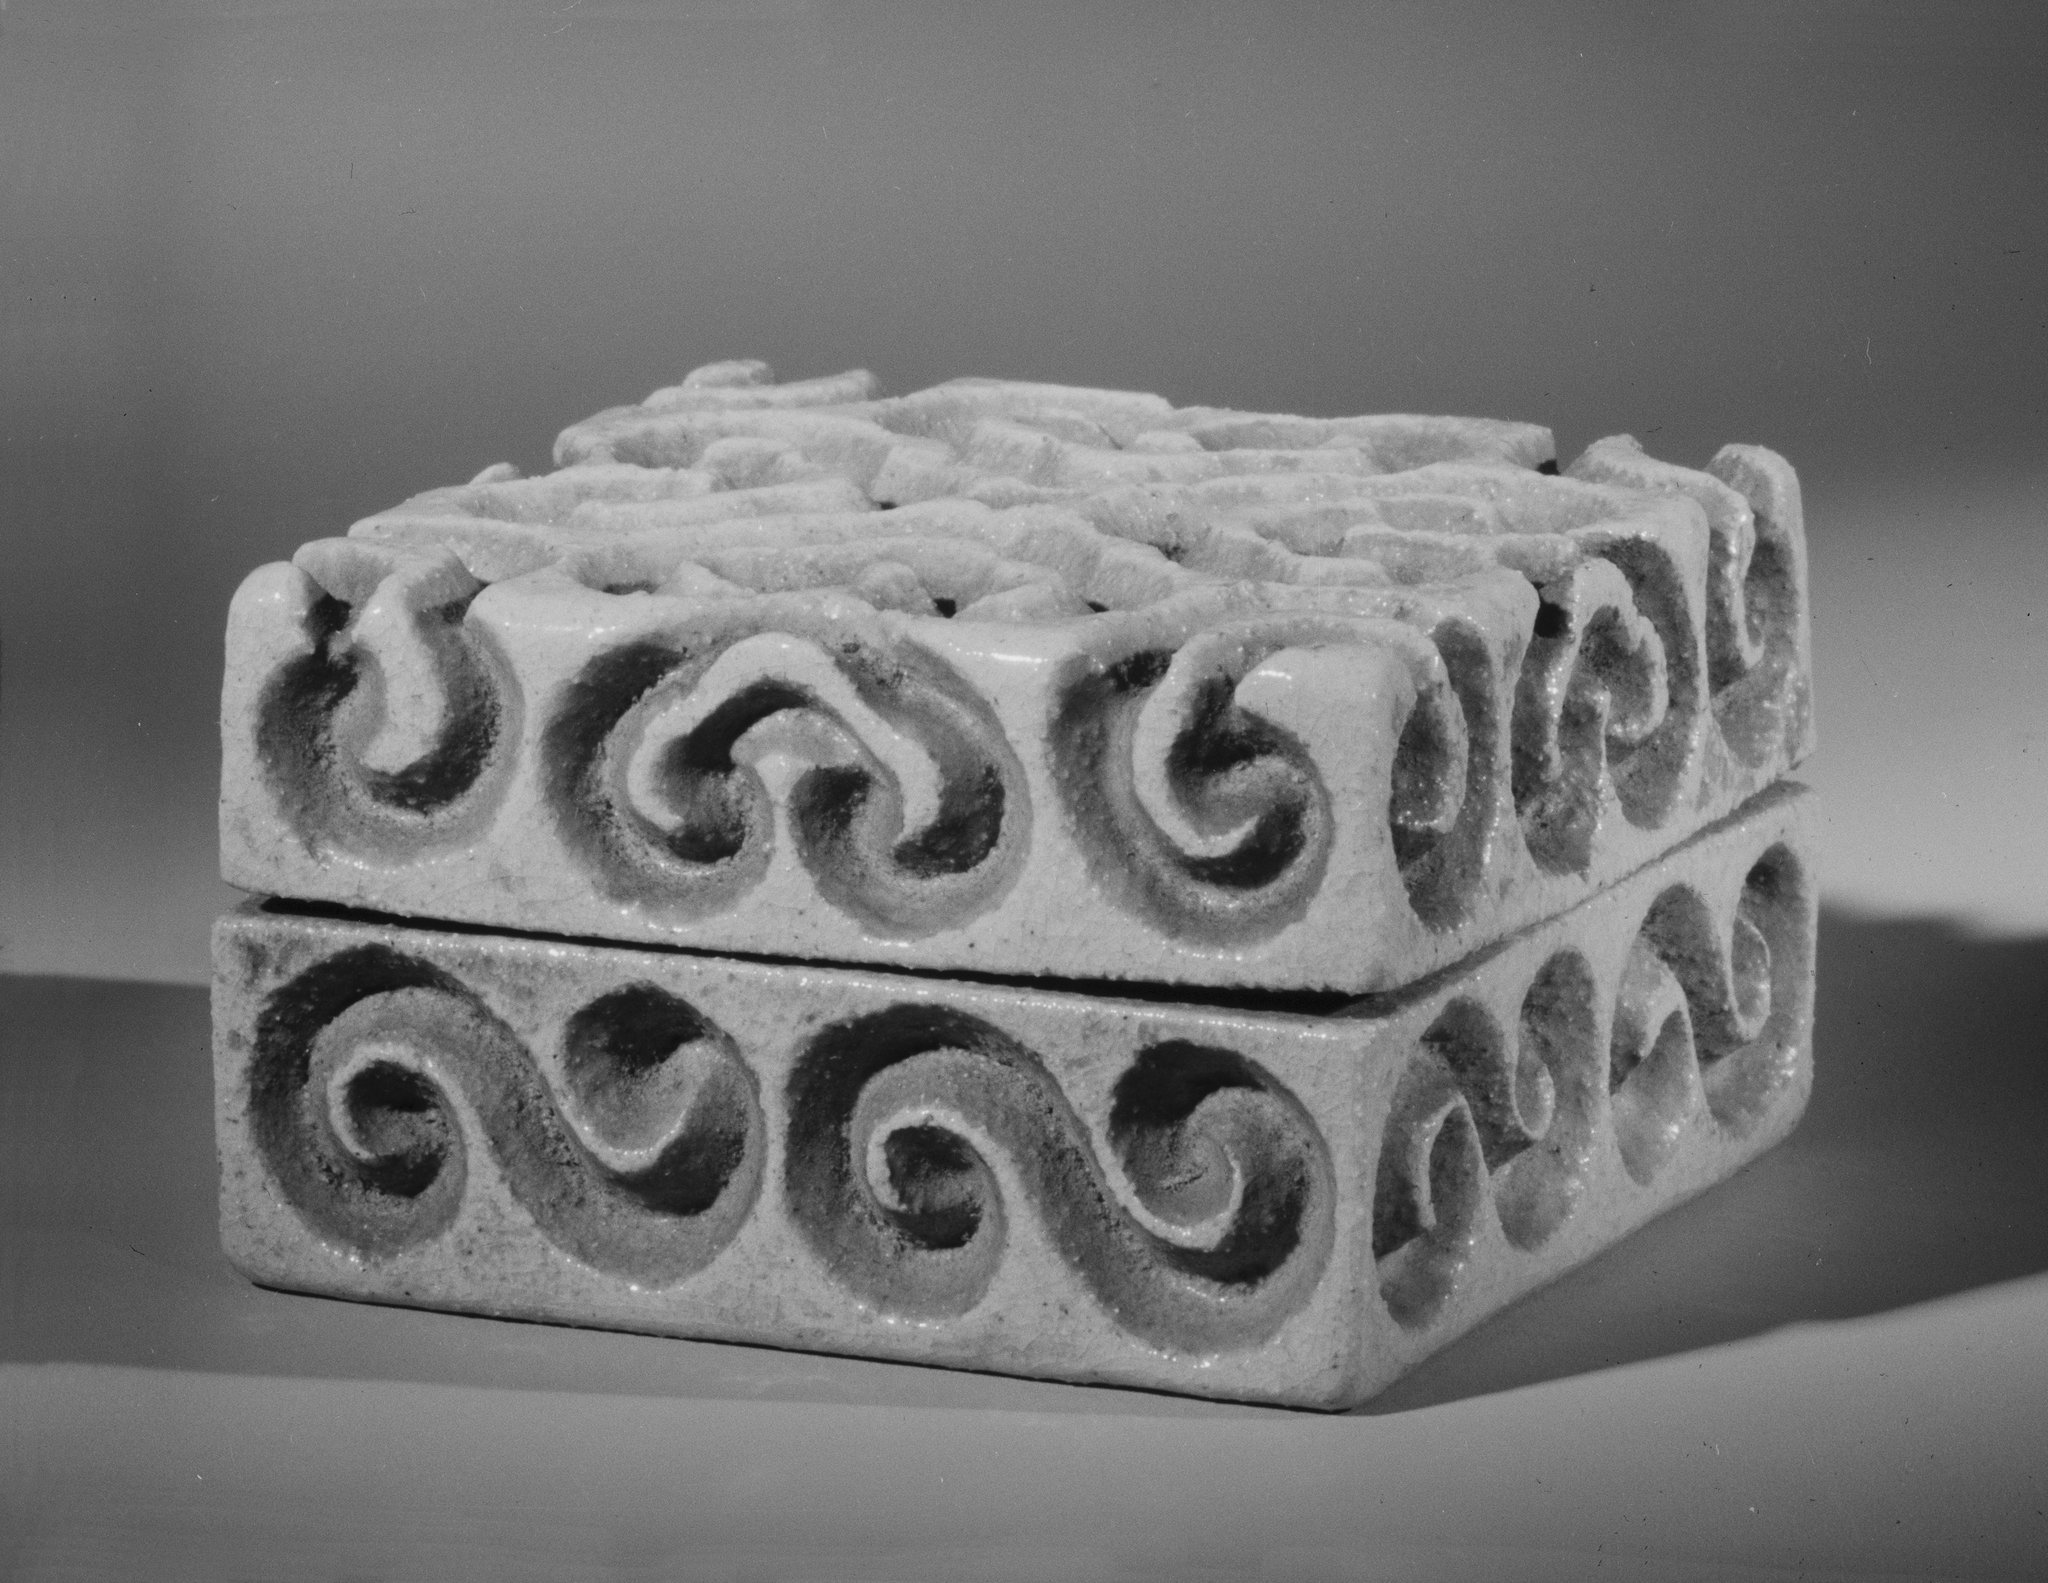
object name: covered incense box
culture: japanese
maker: raku donyu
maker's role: artist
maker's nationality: japanese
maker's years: 1556-1656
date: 1650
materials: glaze, lacquer, pottery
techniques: carving, incising